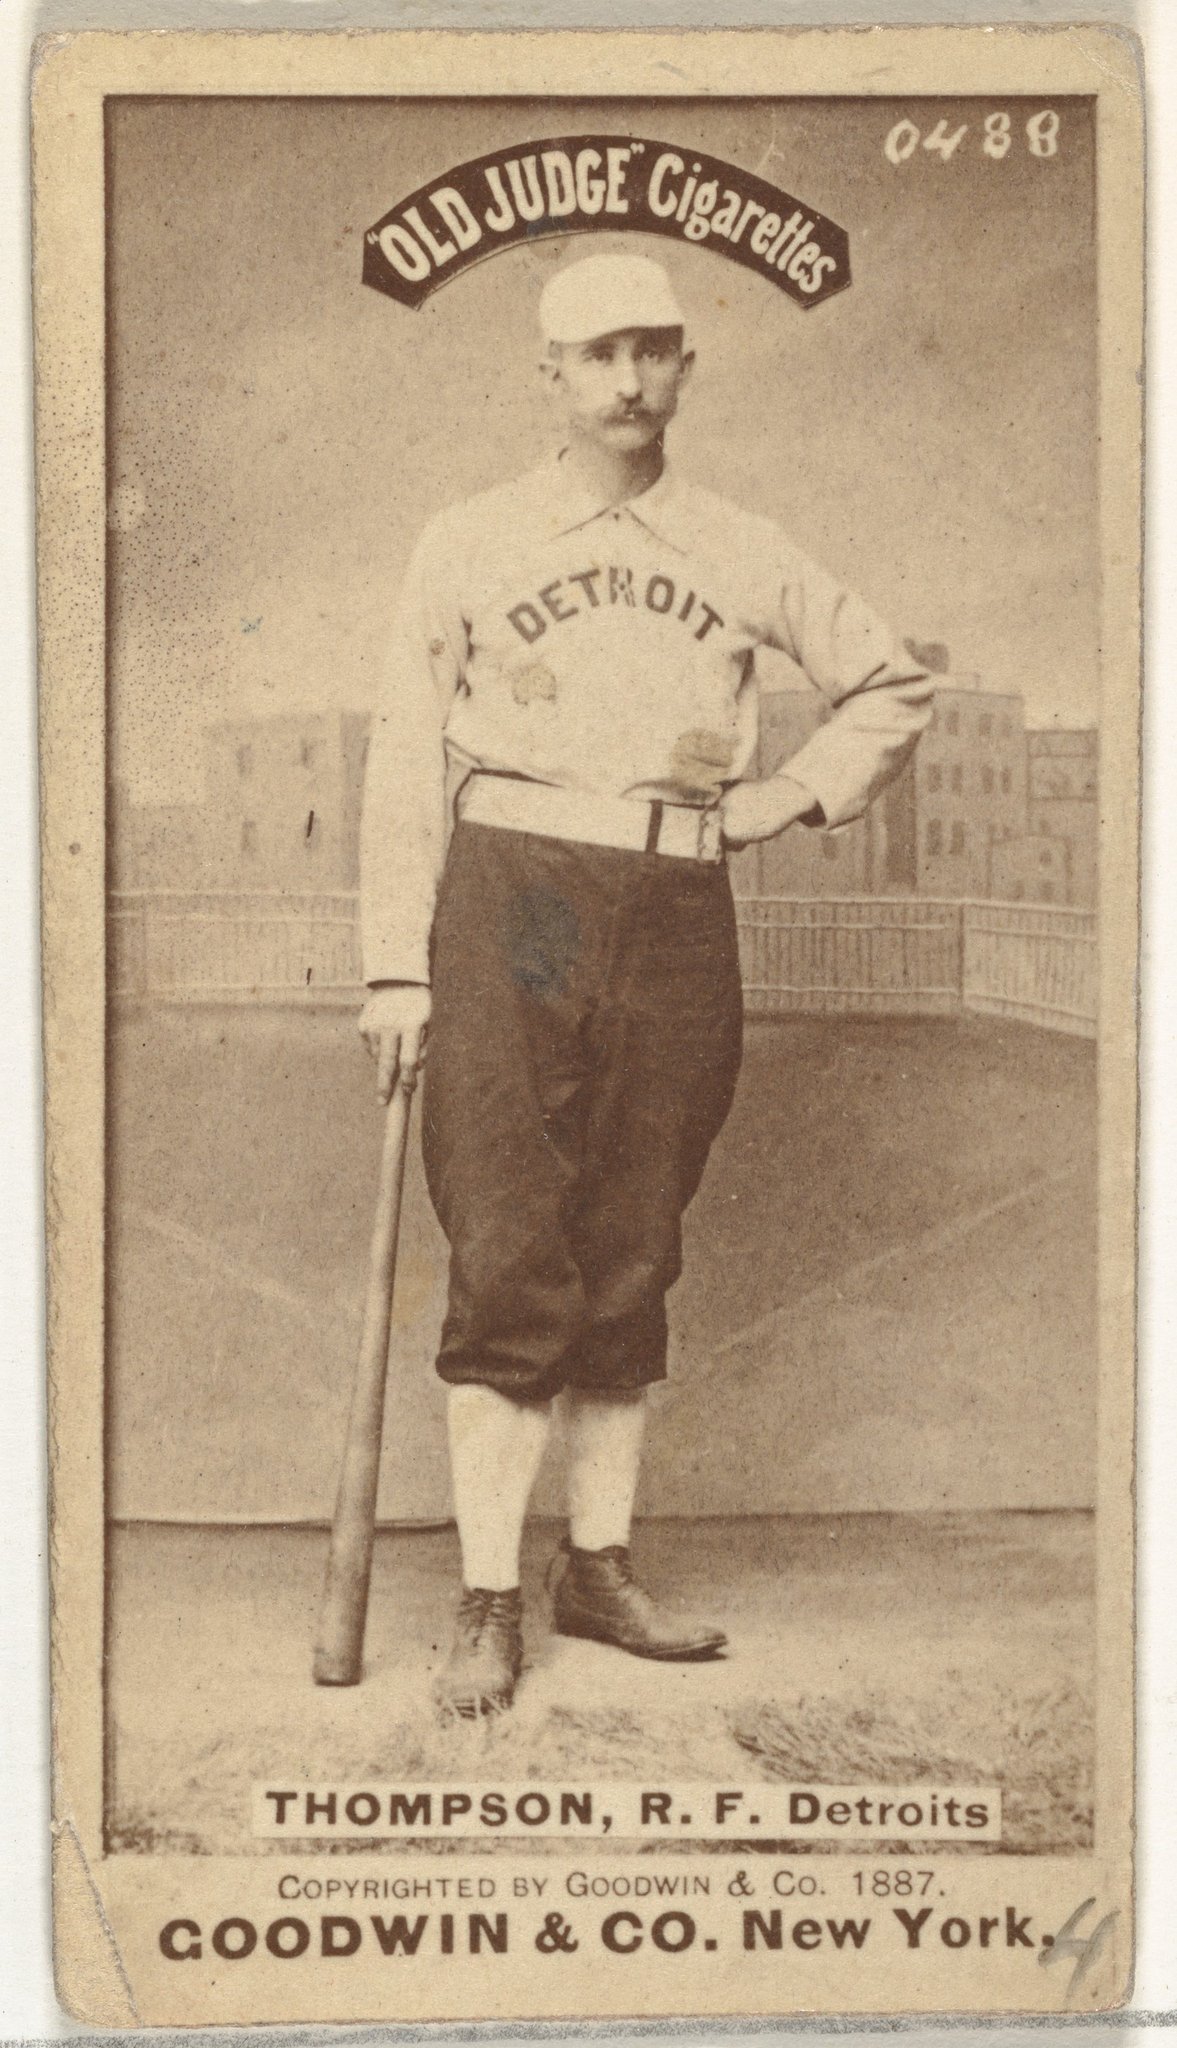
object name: baseball card, photograph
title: Samuel Luther "Sam" Thompson, Right Field, Detroit Wolverines, from the Old Judge series (N172) for Old Judge Cigarettes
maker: goodwin & company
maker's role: publisher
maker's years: 1850-1950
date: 1887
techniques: albumen silver print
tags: men,portraits,baseball,athletes